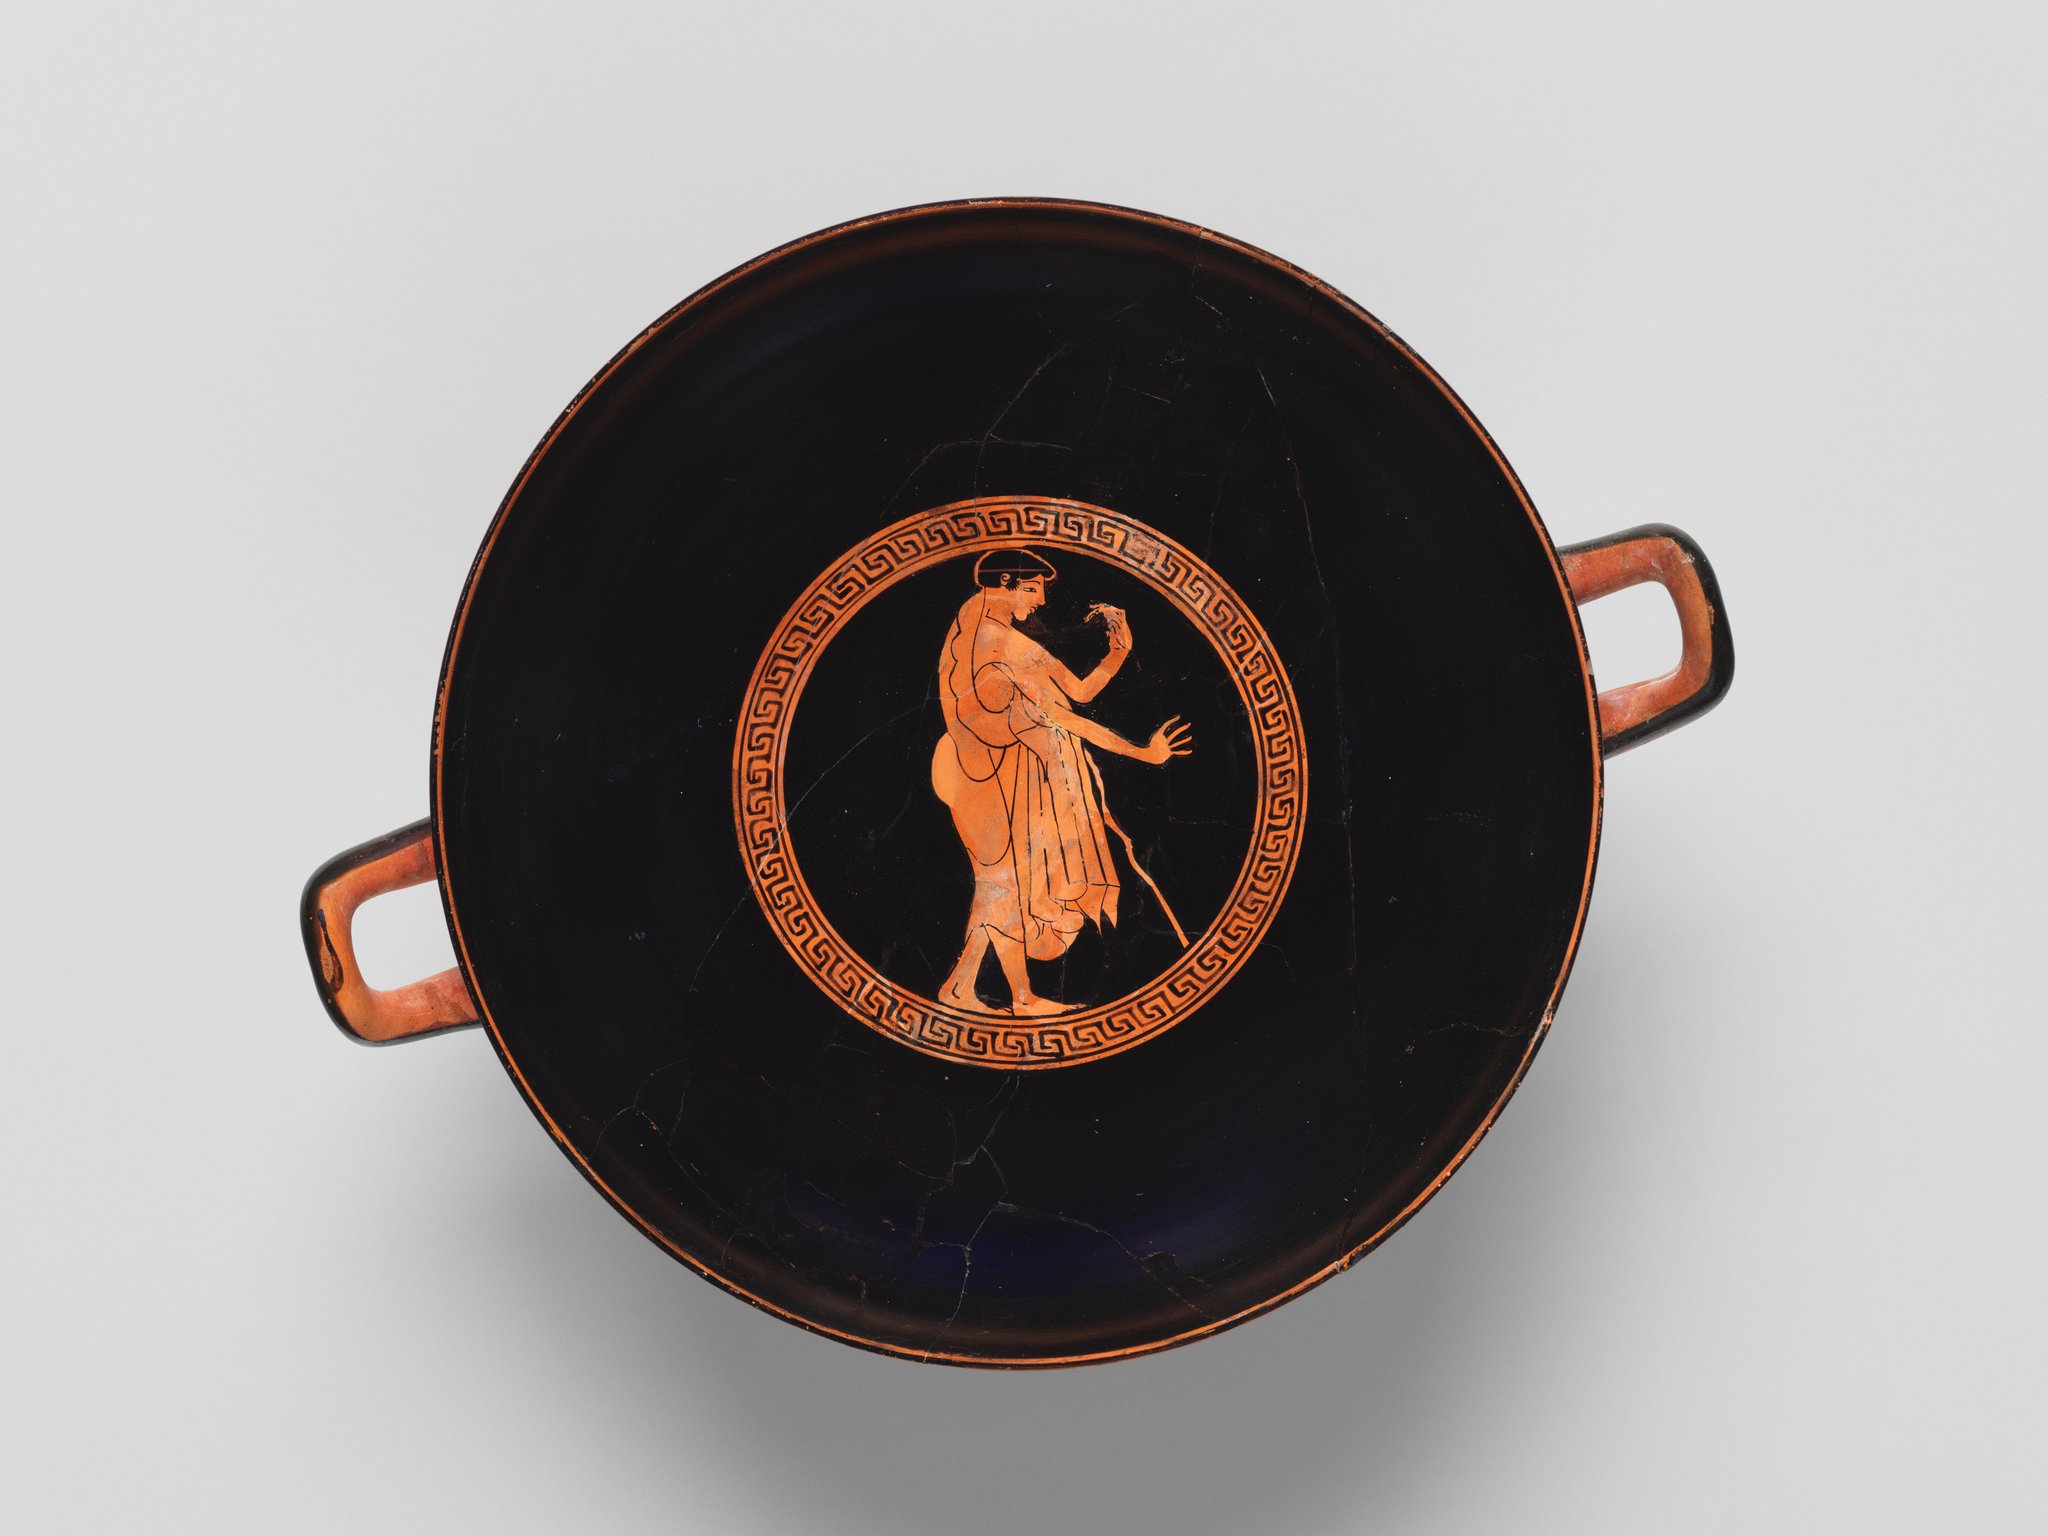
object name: kylix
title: Terracotta kylix (drinking cup)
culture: greek, attic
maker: makron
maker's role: artist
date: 480 BCE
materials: terracotta